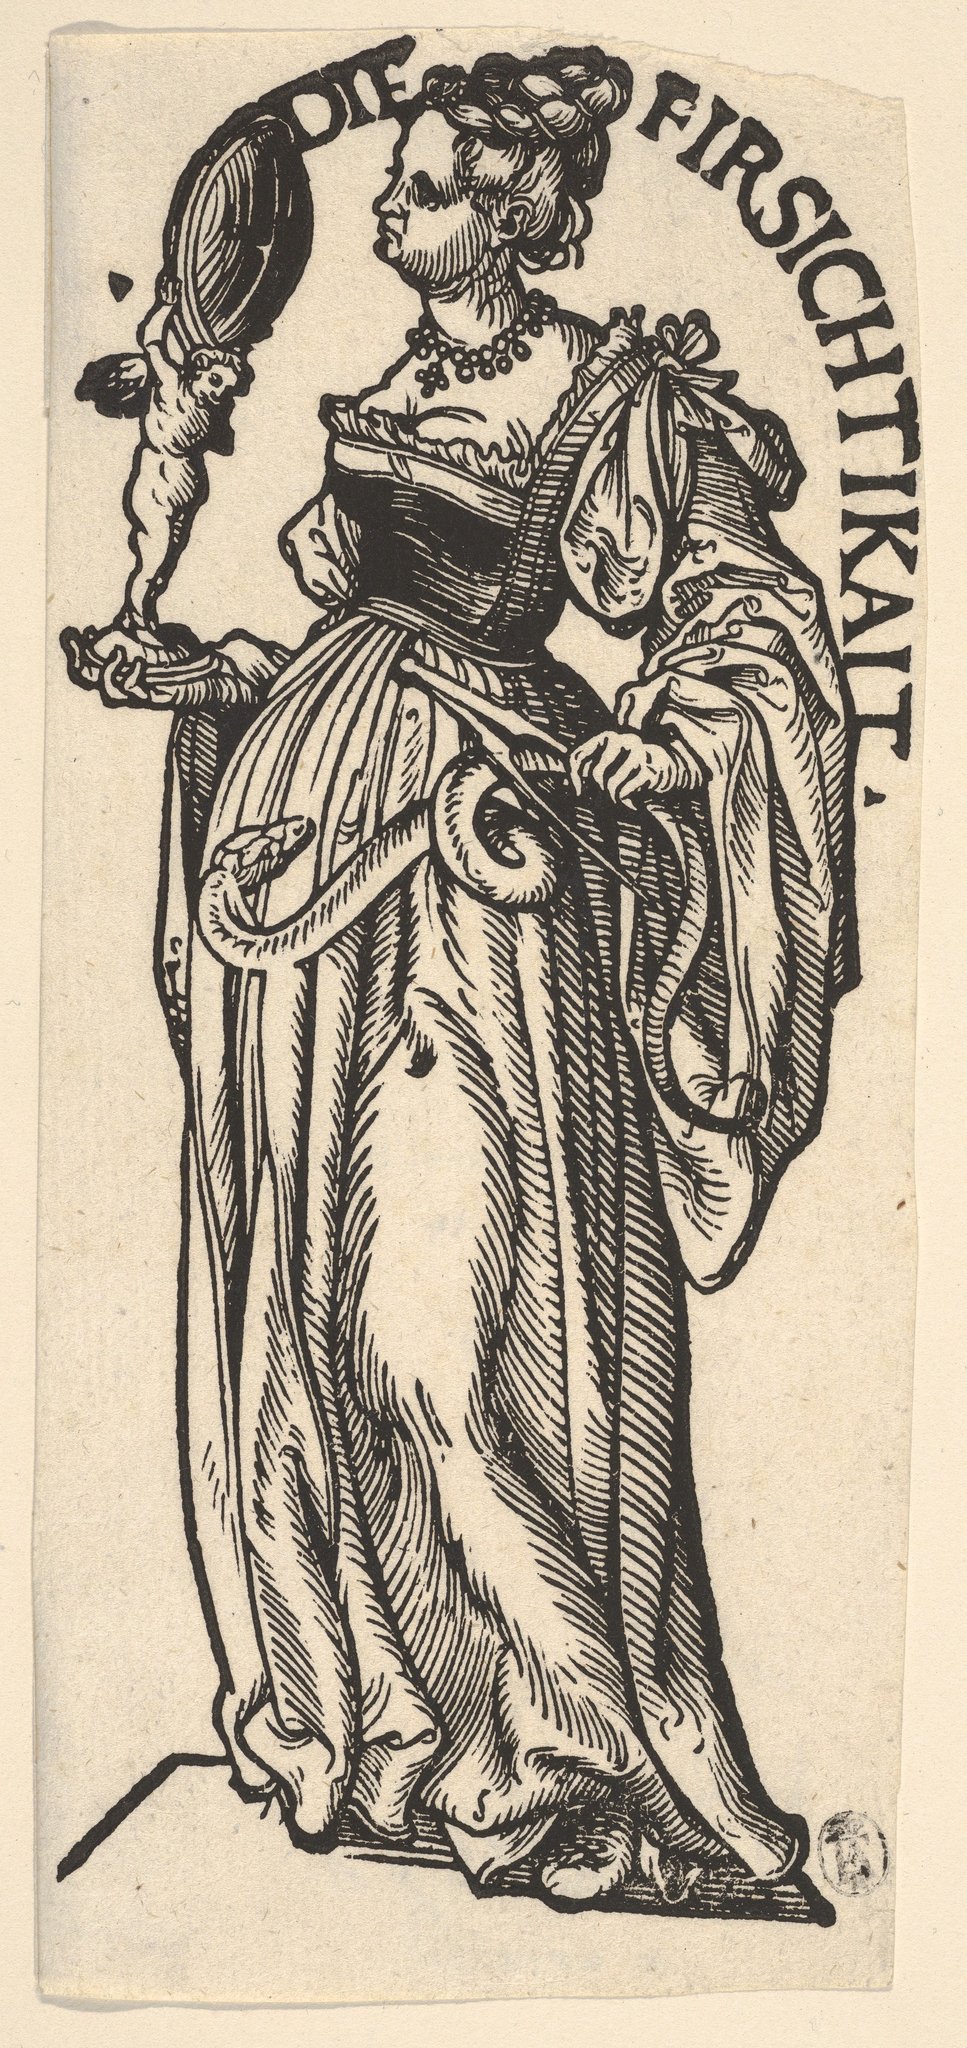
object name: print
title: Prudence (Die Firsichtikait), from "The Seven Virtues"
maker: hans burgkmair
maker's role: artist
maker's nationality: german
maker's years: 1473-1531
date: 1498-1531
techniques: woodcut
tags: women,snakes